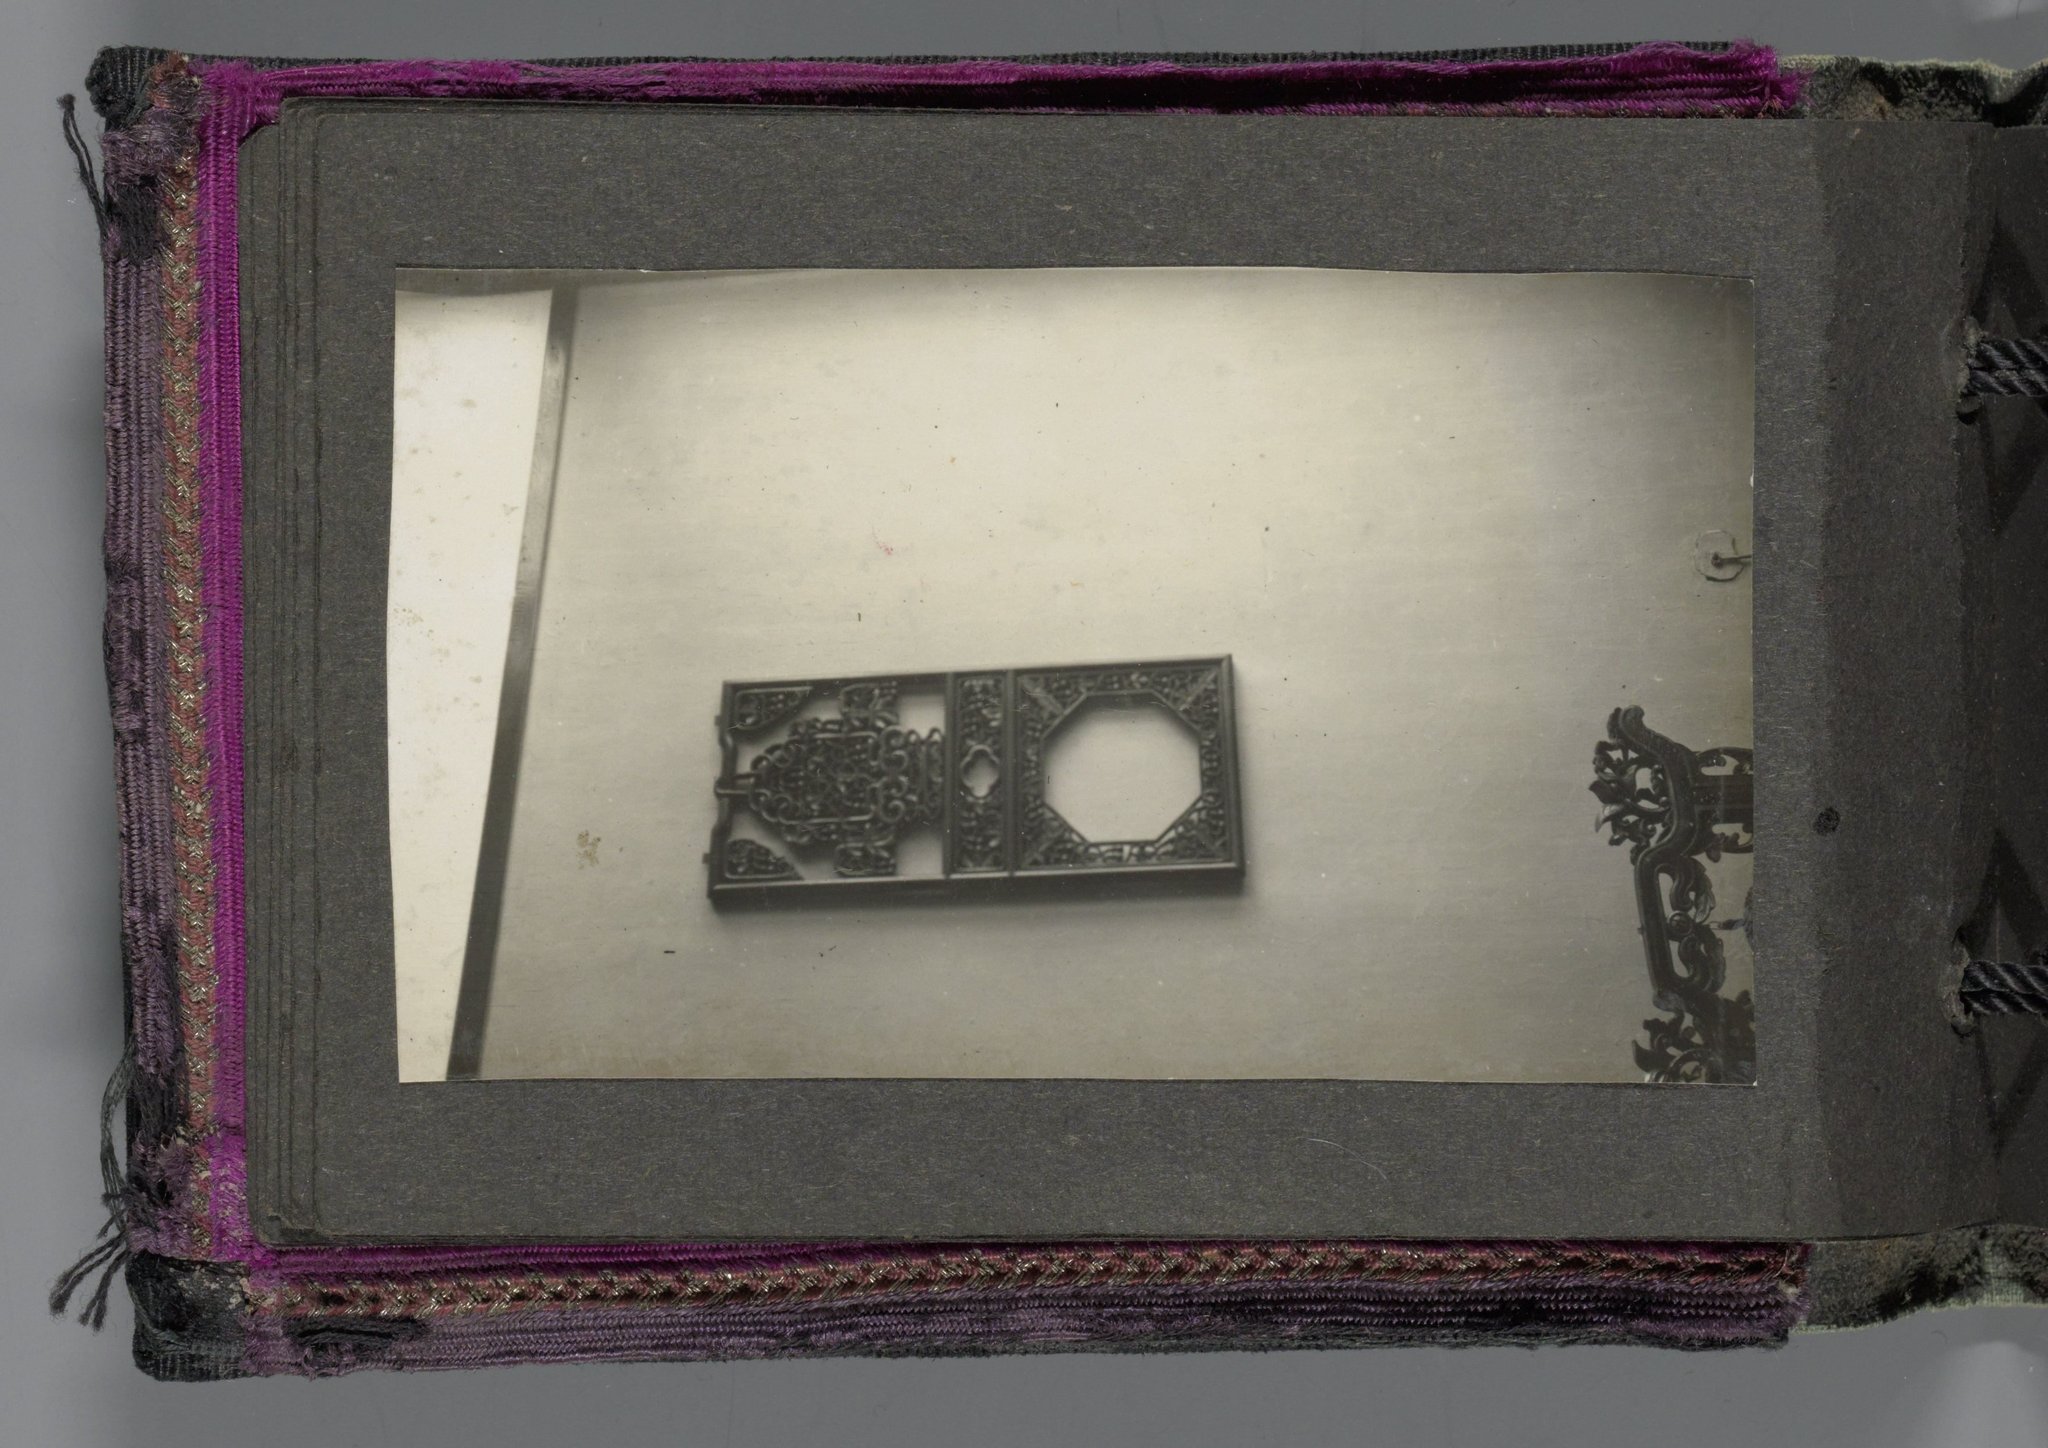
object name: photograph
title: Zitkamer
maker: elsa silberstein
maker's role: amateurfotograaf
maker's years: -2006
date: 1935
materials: photographic support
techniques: gelatin silver print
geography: bandung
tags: amsterdam, elsa silberstein, interior of the house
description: Hoek van de zitkamer met een bank, een Chinees beeldhouwwerk op een tafeltje en borden aan de wand. In het woonhuis van Elsa Silberstein en haar man, thesaurier-generaal in Bandung in 1935. Schilderijtjes aan de muur. Onderdeel van het fotoalbum met zwart-wit foto's van het interieur van het huis van de familie Silberstein in Bandung in Nederlands-Indië.